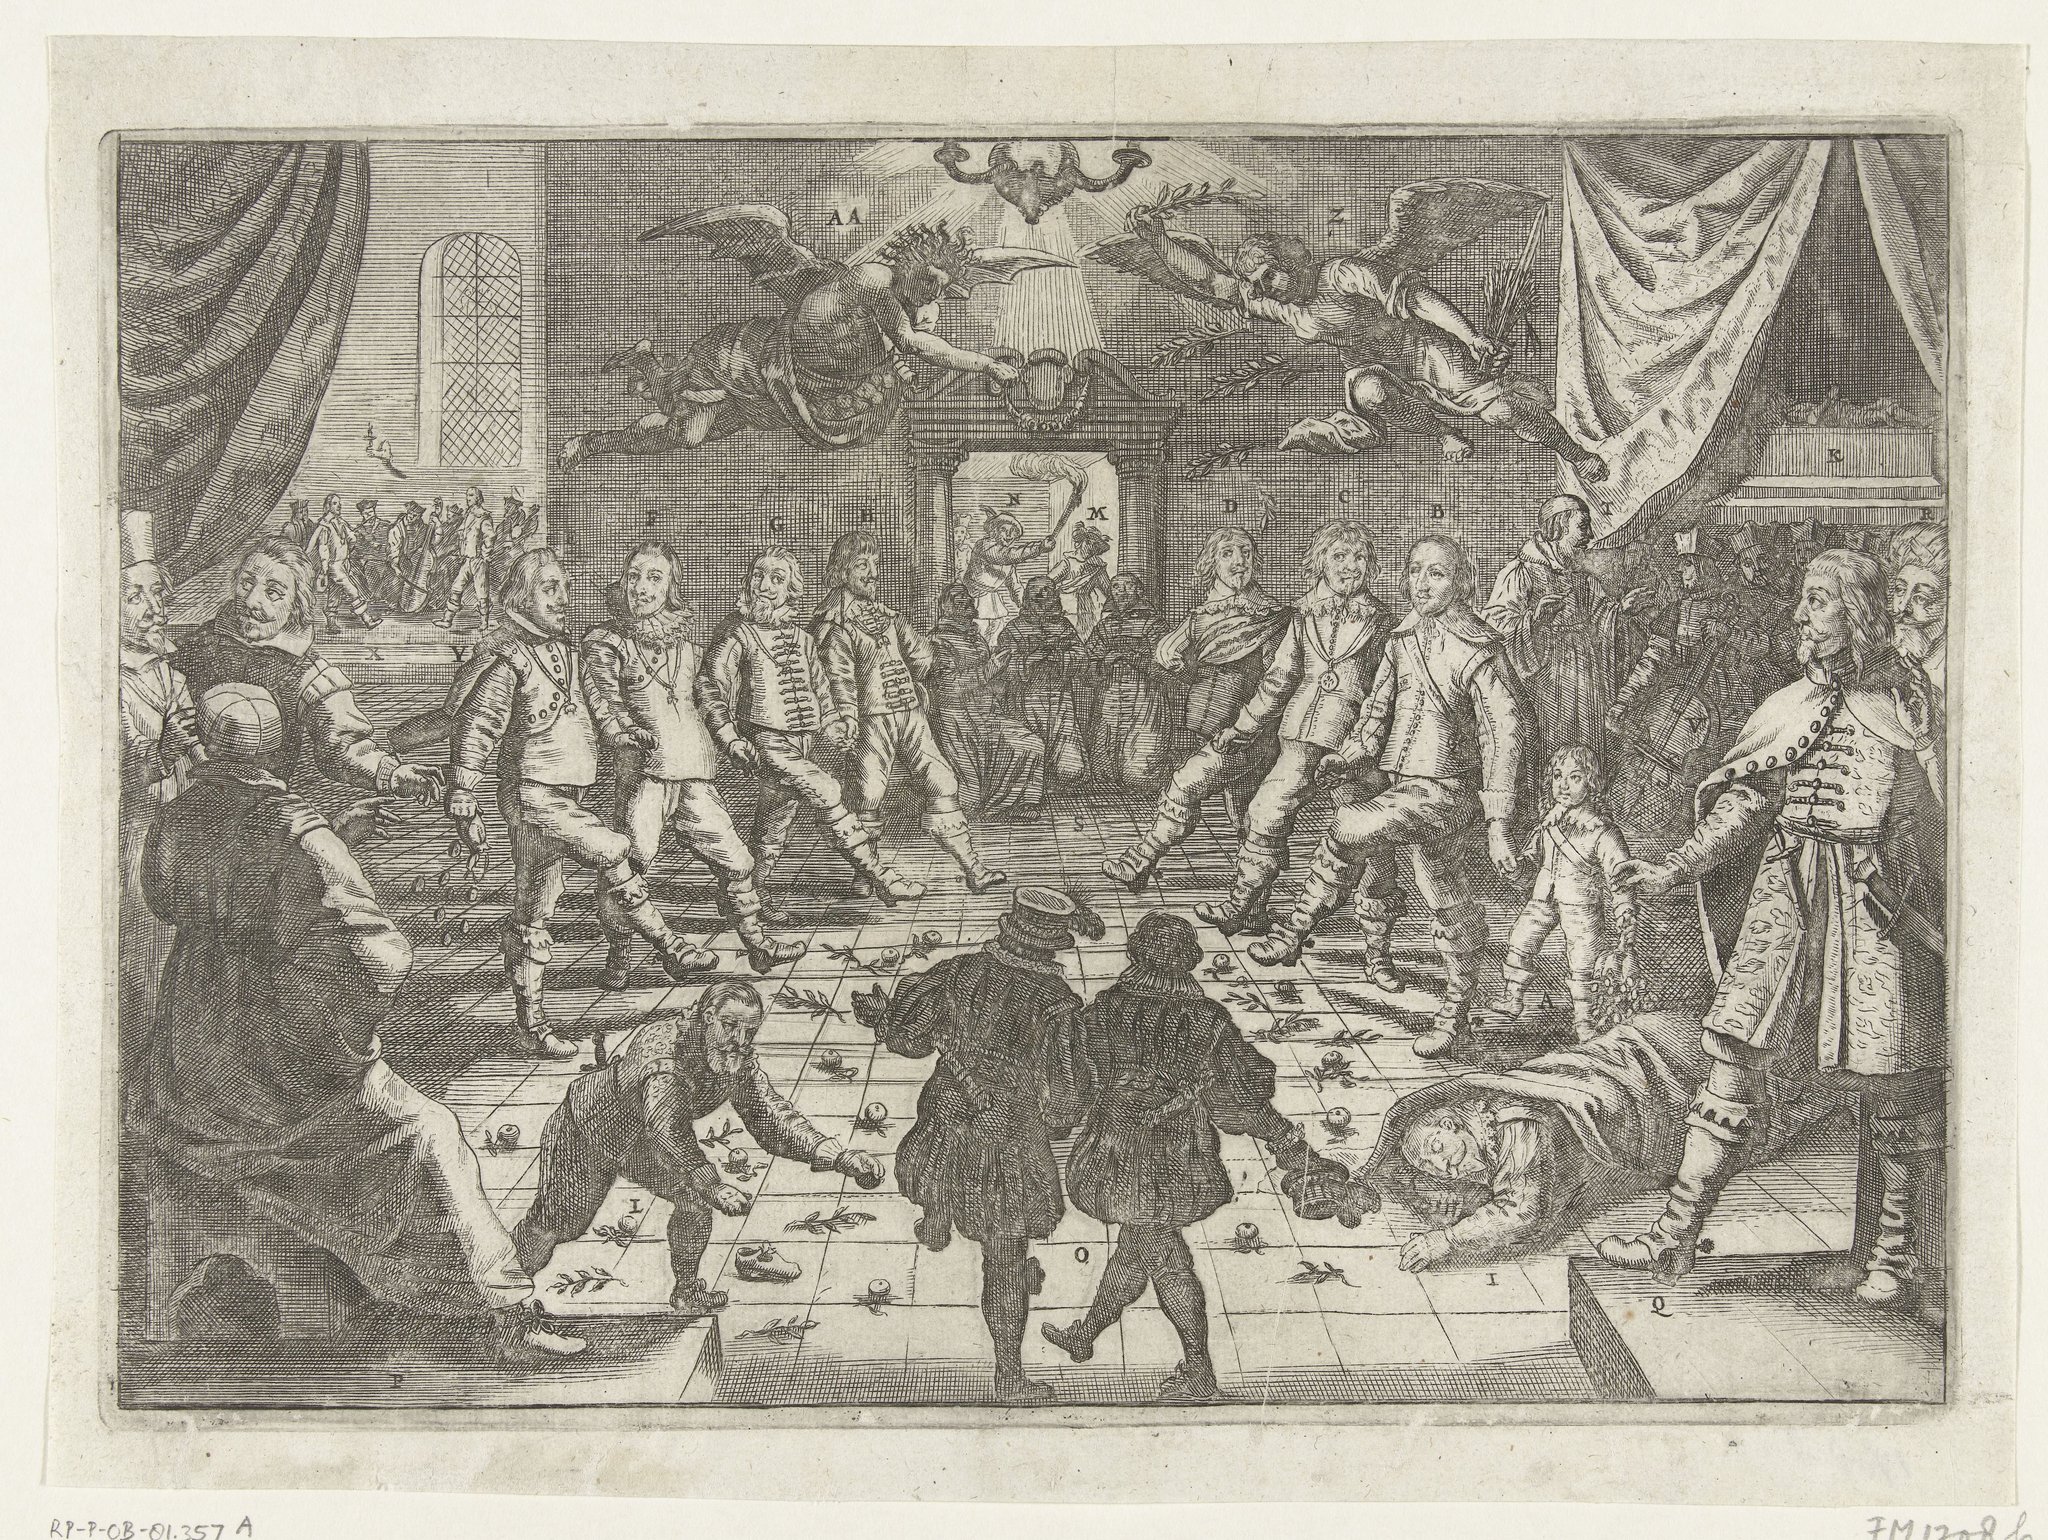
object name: print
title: Spotprent op de vredesonderhandelingen met Spanje, 1632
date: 1643-1645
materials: paper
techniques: engraving, etching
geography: northern netherlands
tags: delft, frederick henry (prince of orange), filips iv (koning van spanje), lodewijk xiv (koning van frankrijk), vienna, ferdinand ii (duits keizer), copenhagen (city), christiaan iv (koning van denemarken en noorwegen), rome, clergyman, urbanus viii, karel i (koning van engeland), brussels, landvoogd der zuidelijke nederlanden ferdinand van oostenrijk, lodewijk xiii (koning van frankrijk), peace negotiations, group dancing, political caricatures and satires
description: Spotprent op de vredesonderhandelingen met Spanje, 1632. Balzaal waarin de Europese vorsten samen dansen. Op de vloer liggen olijftakken en twistappels, gestrooid door de Vrede en de Nijd die in de lucht vliegen. Rechts de Franse koning Lodewijk XIII met de Dauphin, prins Frederik Hendrik en de Zweedse generaal Torstenson (Banier), links de Spaanse koning Filips IV, keizer Ferdinand II, de hertog van Beieren en de Kardinaal-Infant Ferdinand van Oostenrijk. Op de voorgrond kijken toe links de hertogen van Venetië, Florence en Genua en rechts de vorst Ragotzi. Dood onder een kleed ligt Gustaaf II Adolf, koning van Zweden. Op de achtergrond rechts speelt een orkestje van jezuïeten onder leiding van paus Urbanus VIII. Op de achtergrond links dansen de Engelse koning Karel I en de graaf van Essex (Robert Devereux?). Bij de prent behoort een tekstblad met een lied in 28 coupletten en de legenda A-AA in het Nederlands.